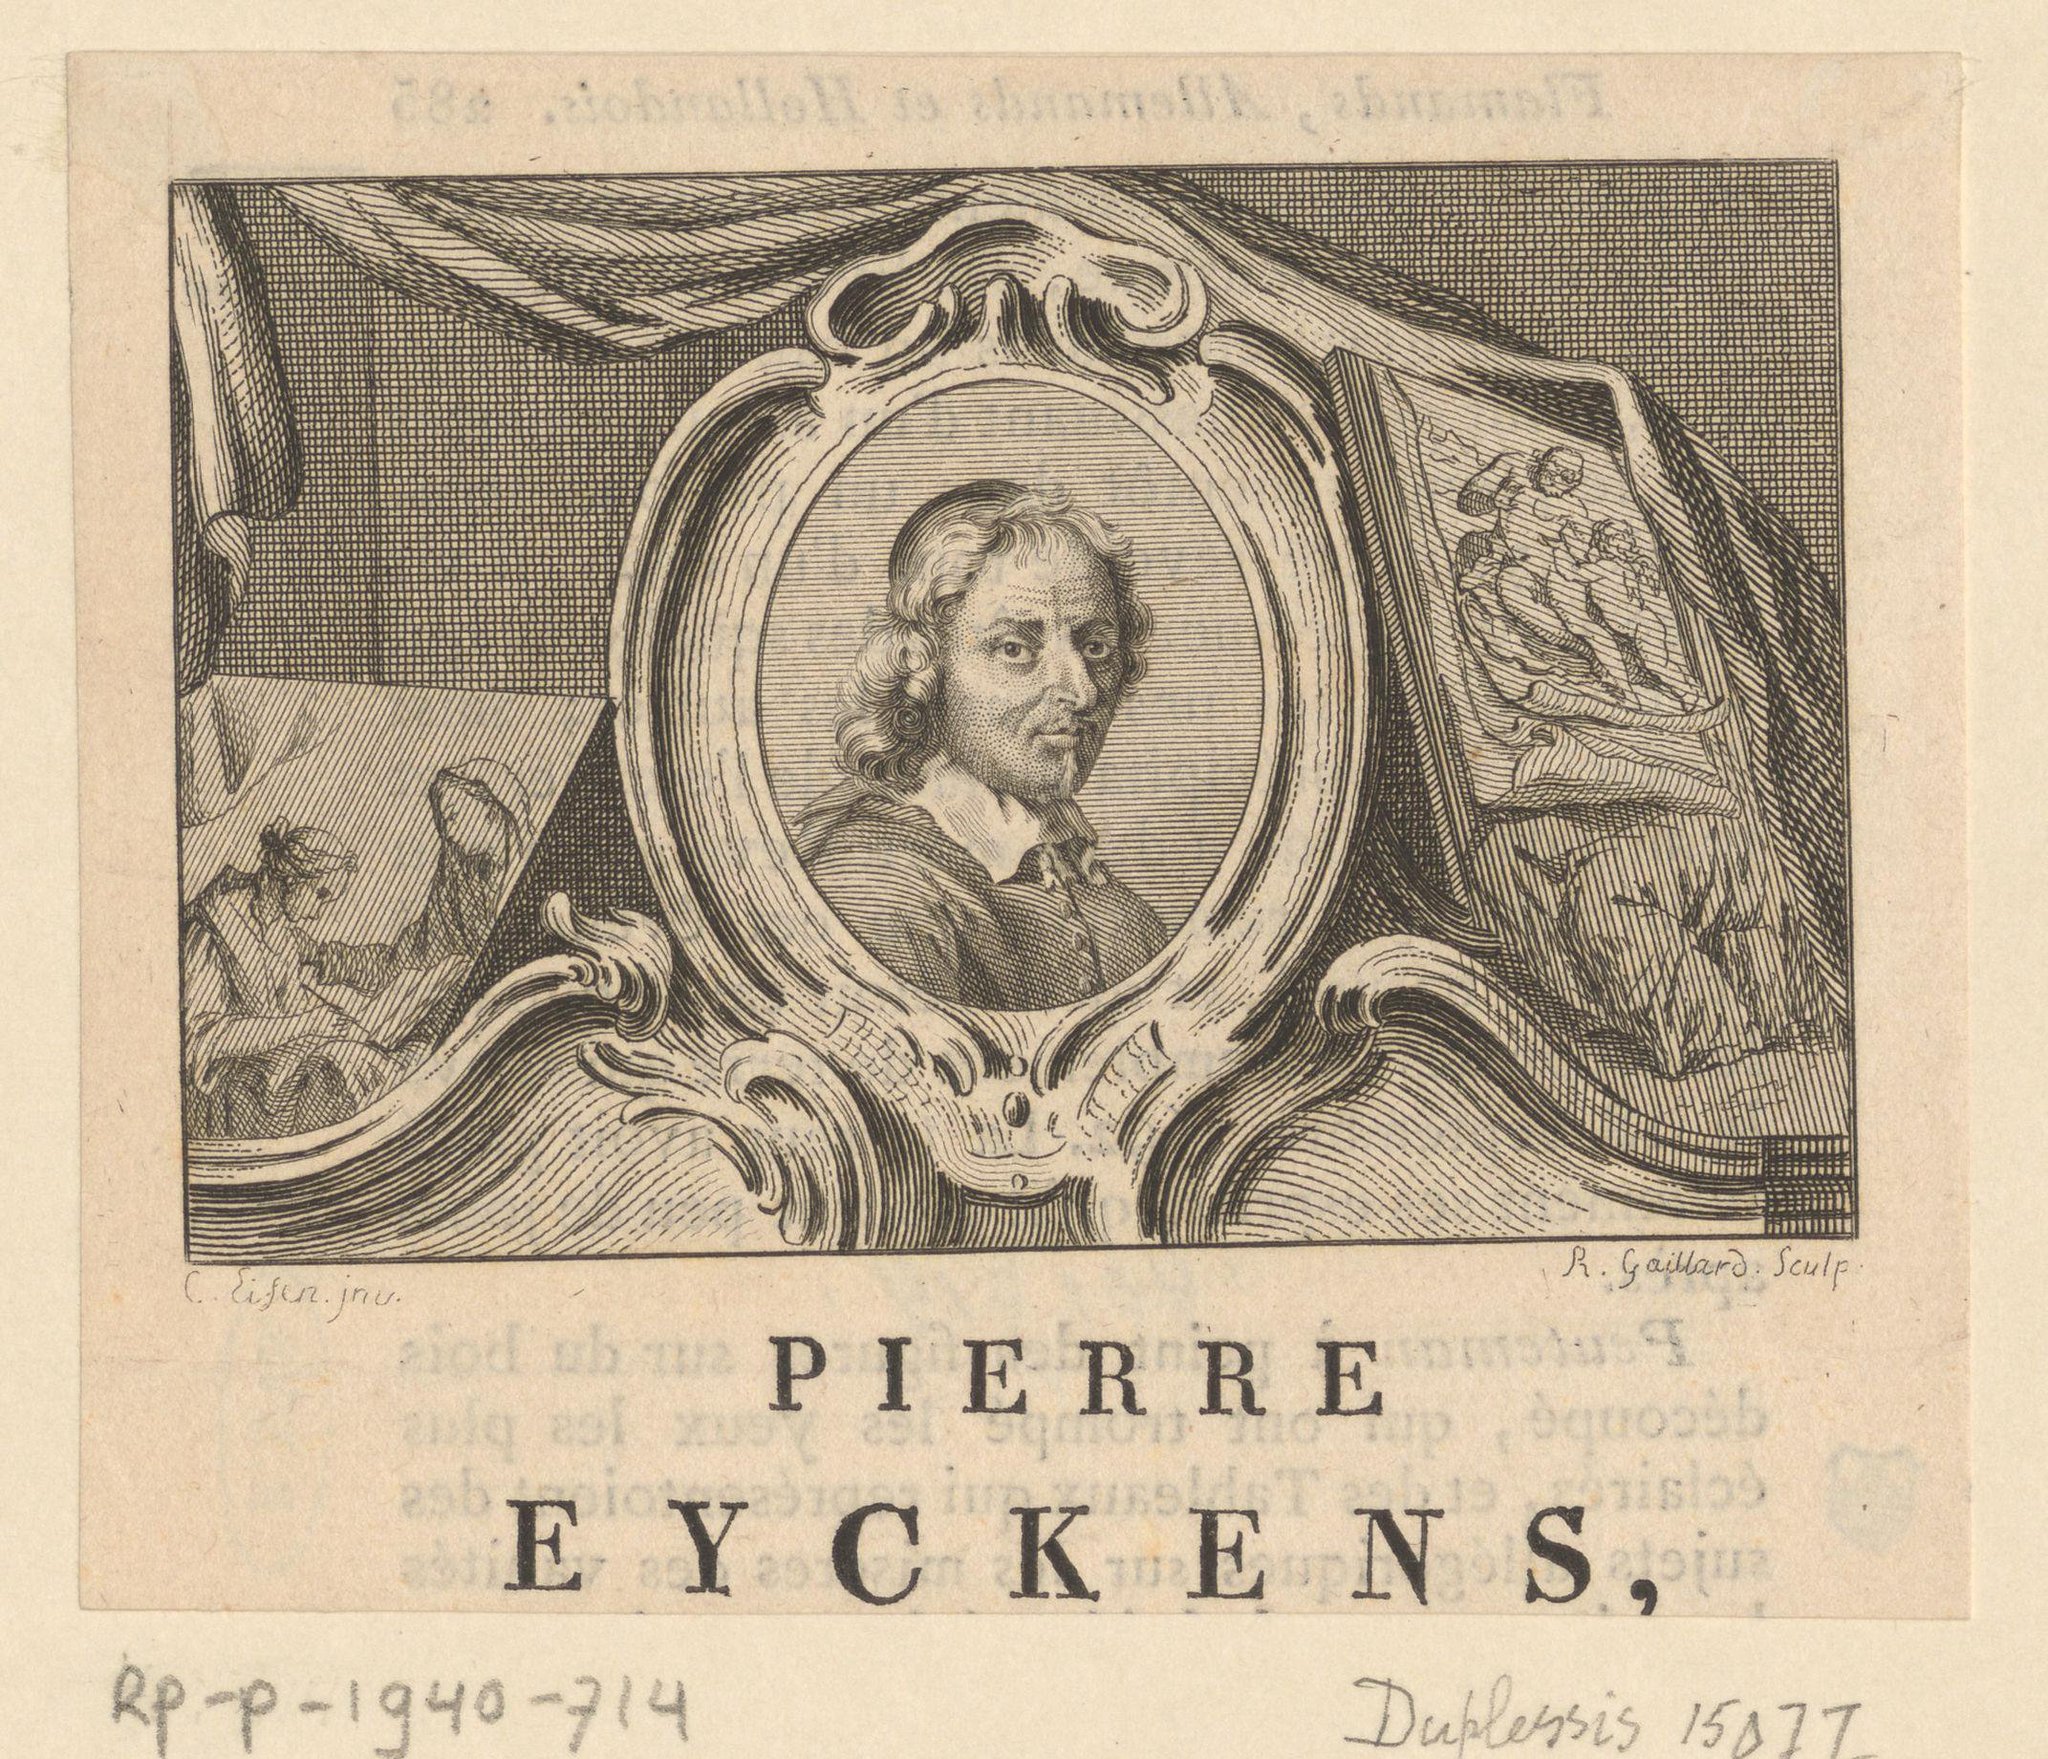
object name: print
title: Portret van Peter Ykens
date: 1760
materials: paper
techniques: etching, letterpress printing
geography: paris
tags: antwerp, peter ykens, historical persons, portrait, self-portrait of painter, picture, painting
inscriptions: collector's mark: Lugt 2760, collector's mark: Lugt 2228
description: Prent uit: Descamps, Jean-Baptiste. La vie des peintres Flamands, Allemands et Hollandois (...). Parijs: Desaint & Saillant et al., 1760, dl. 3.